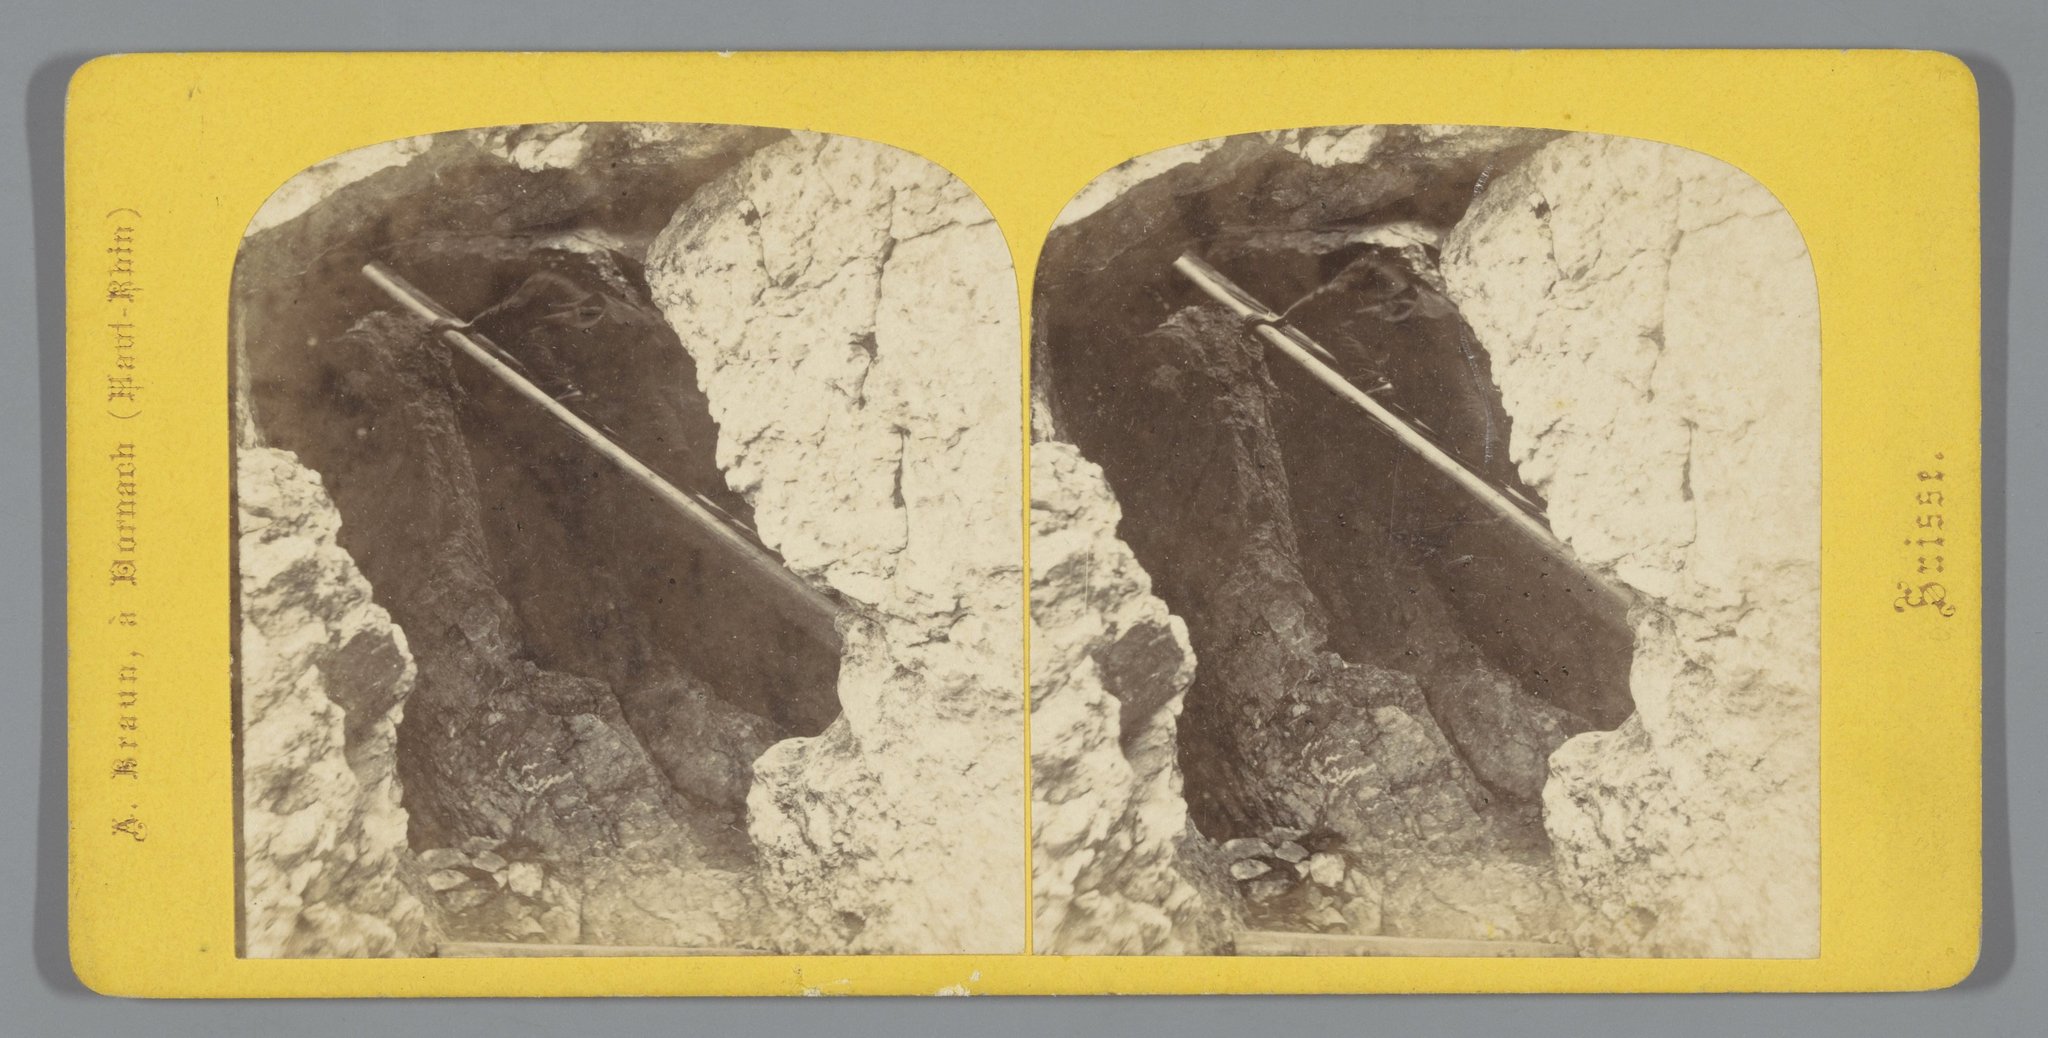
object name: stereograph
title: Chriesiloch tunnel door het Pilatus-massief, Zwitserland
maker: Anonymous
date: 1879-1889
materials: cardboard, paper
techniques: albumen print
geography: dornach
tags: mountain climbing, mountaineering, underground road, tunnel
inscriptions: number: ‘No 4628.’